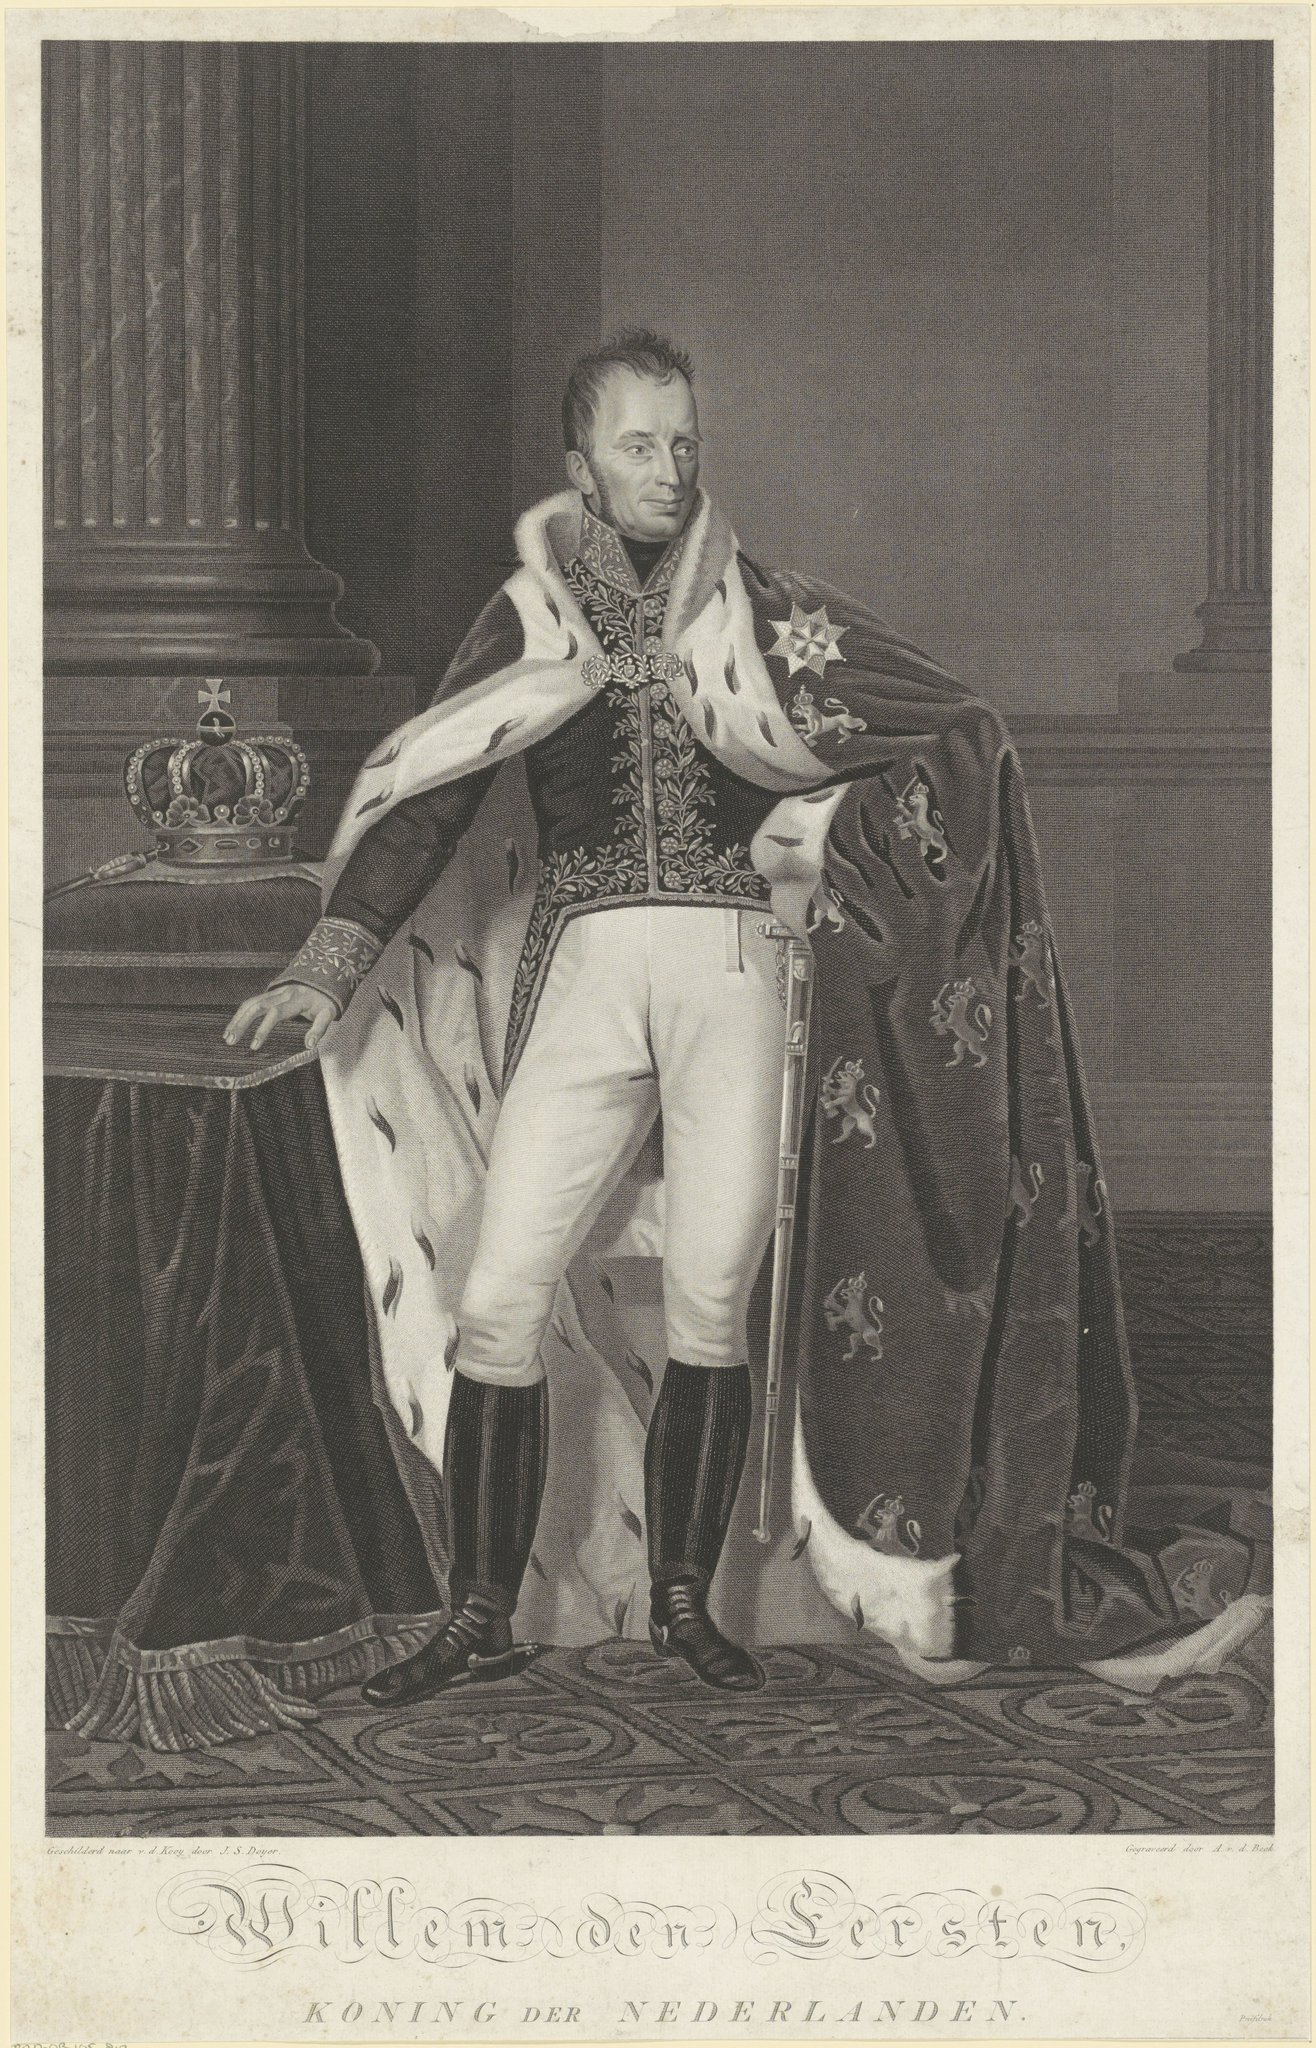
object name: print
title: Portret van Willem I Frederik, koning der Nederlanden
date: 1815-1852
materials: paper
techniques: engraving, etching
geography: netherlands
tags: berlin, william i of the netherlands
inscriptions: collector's mark: Lugt 963, collector's mark: Lugt 2165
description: Portret van Willem I Frederik met een hermelijnen mantel. Hij staat in een vertrek naast een tafel met daarop een kroon en een scepter. In de ondermarge zijn naam en titel. Rechtsonder 'Proefdruk'.